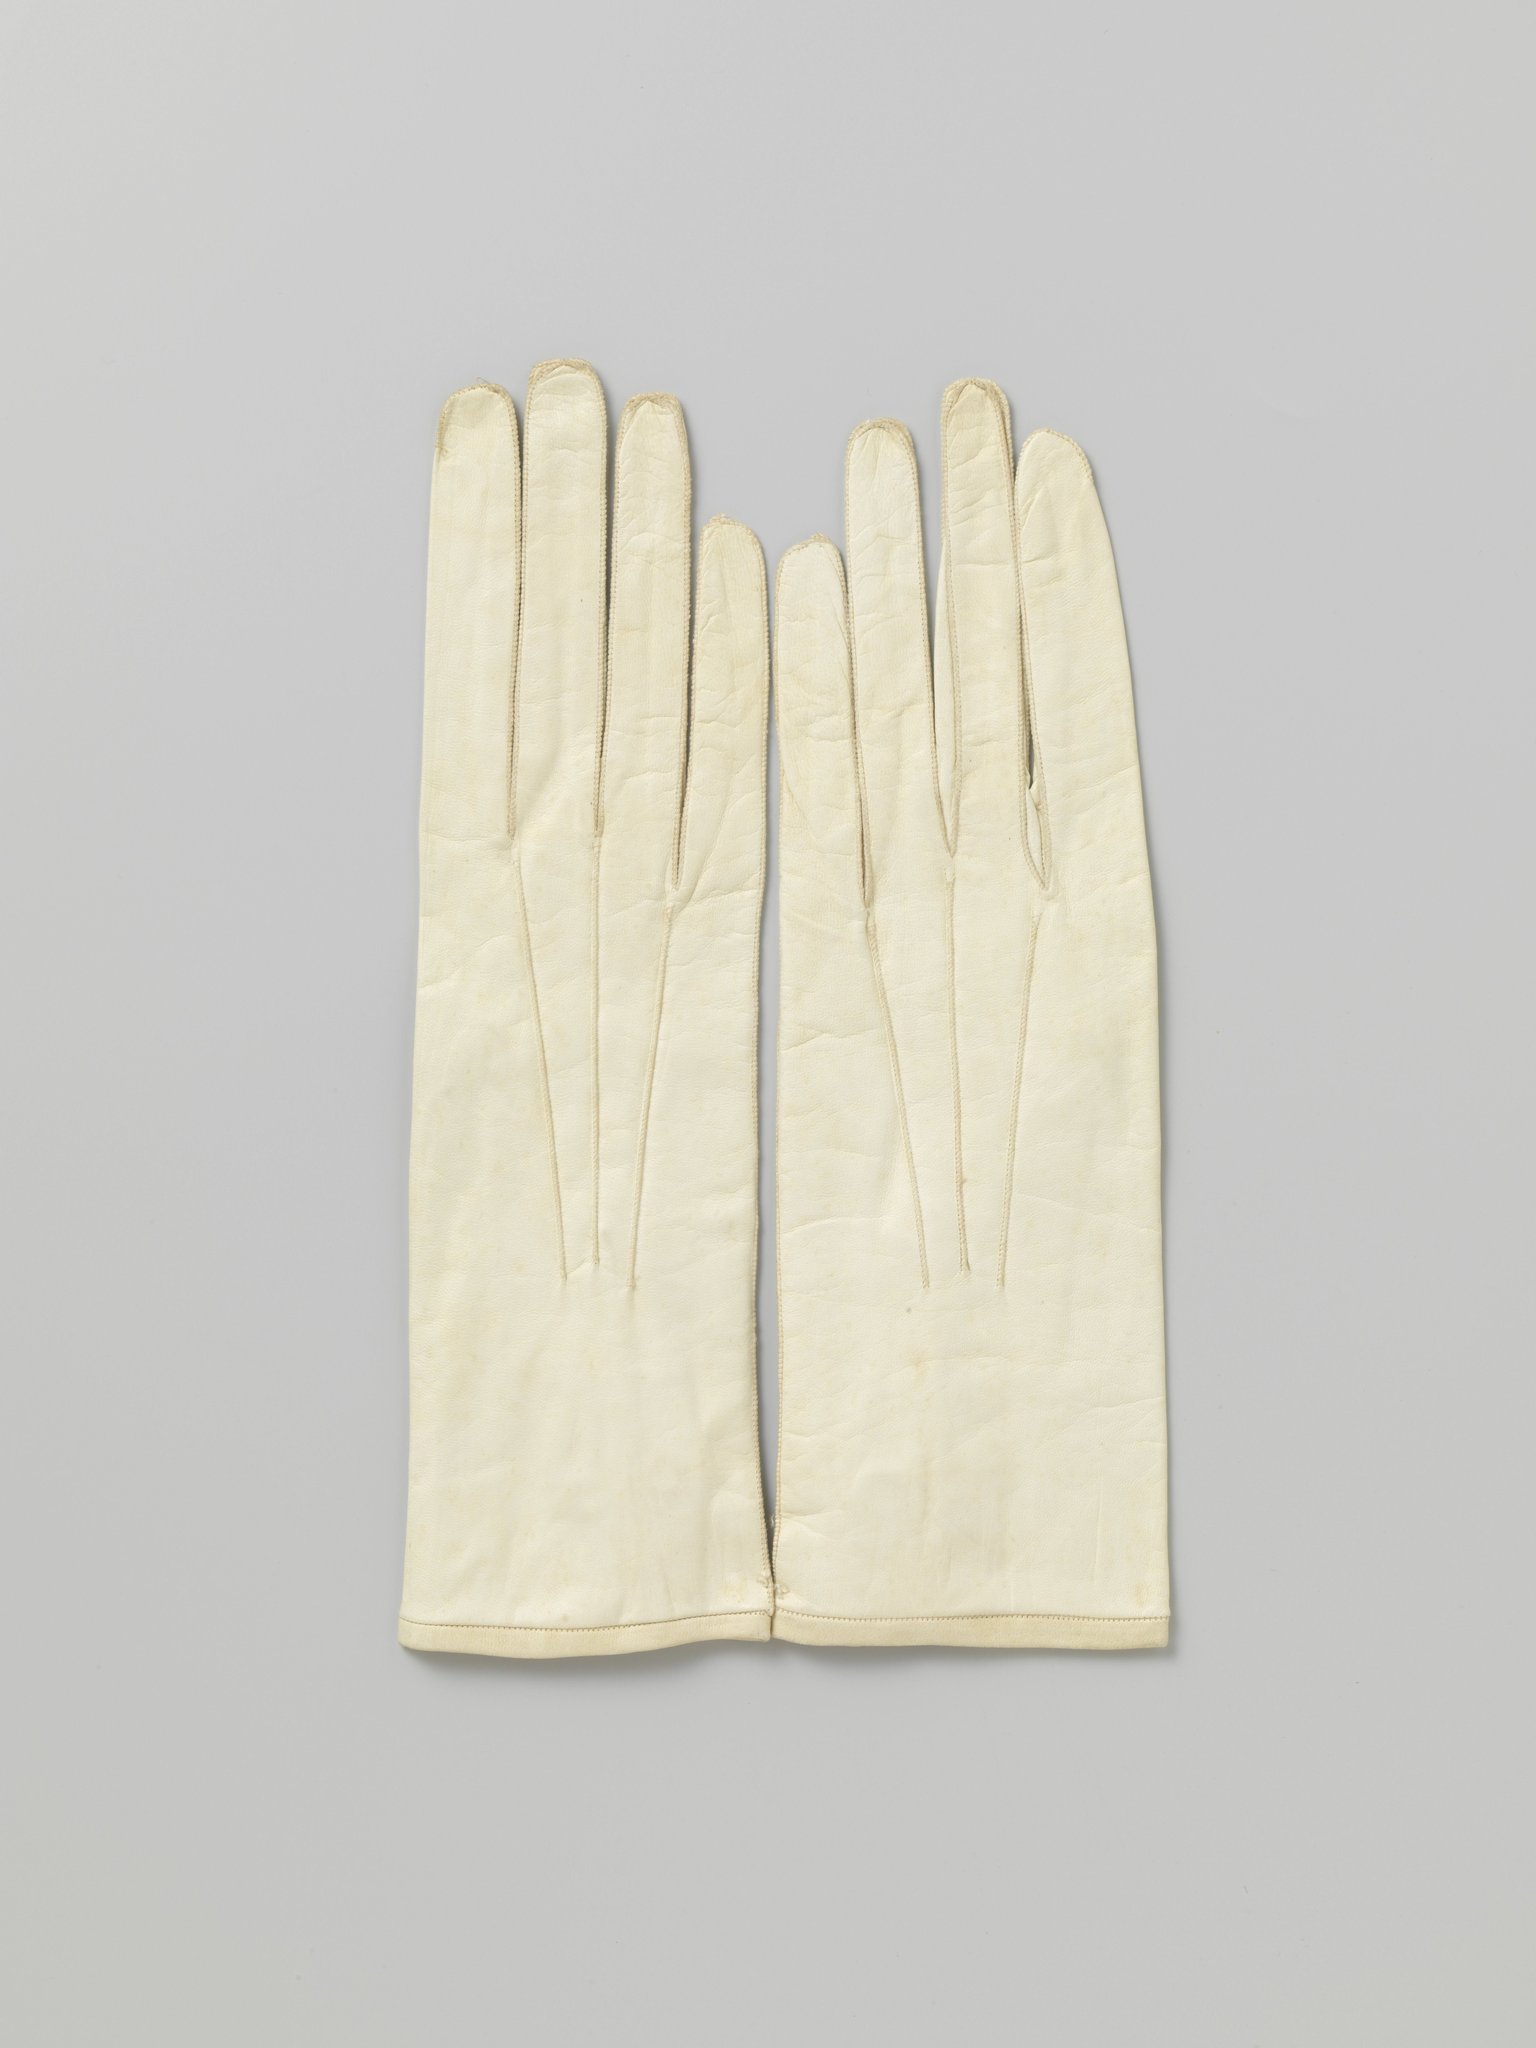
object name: glove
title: Visitehandschoen van wit glacéleer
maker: Anonymous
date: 1900-1925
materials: plastic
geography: western europe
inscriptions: stamp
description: Paar heren-visitehandschoenen van wit glacé leer. Model Kort: Bij het split één drukknoop, met geel benen dopje. Versiering: Op de rug drie uitstralende koordjes, die de peren aanduiden. Maat gedrukt: 8 1/4. Toestand. Winkelnieuw; nog met draadje verbonden. Hetzij nooit gedragen en als voorraad , hetzij wèl gebruikt maar steeds met z'n tweeën in de hand gehouden.